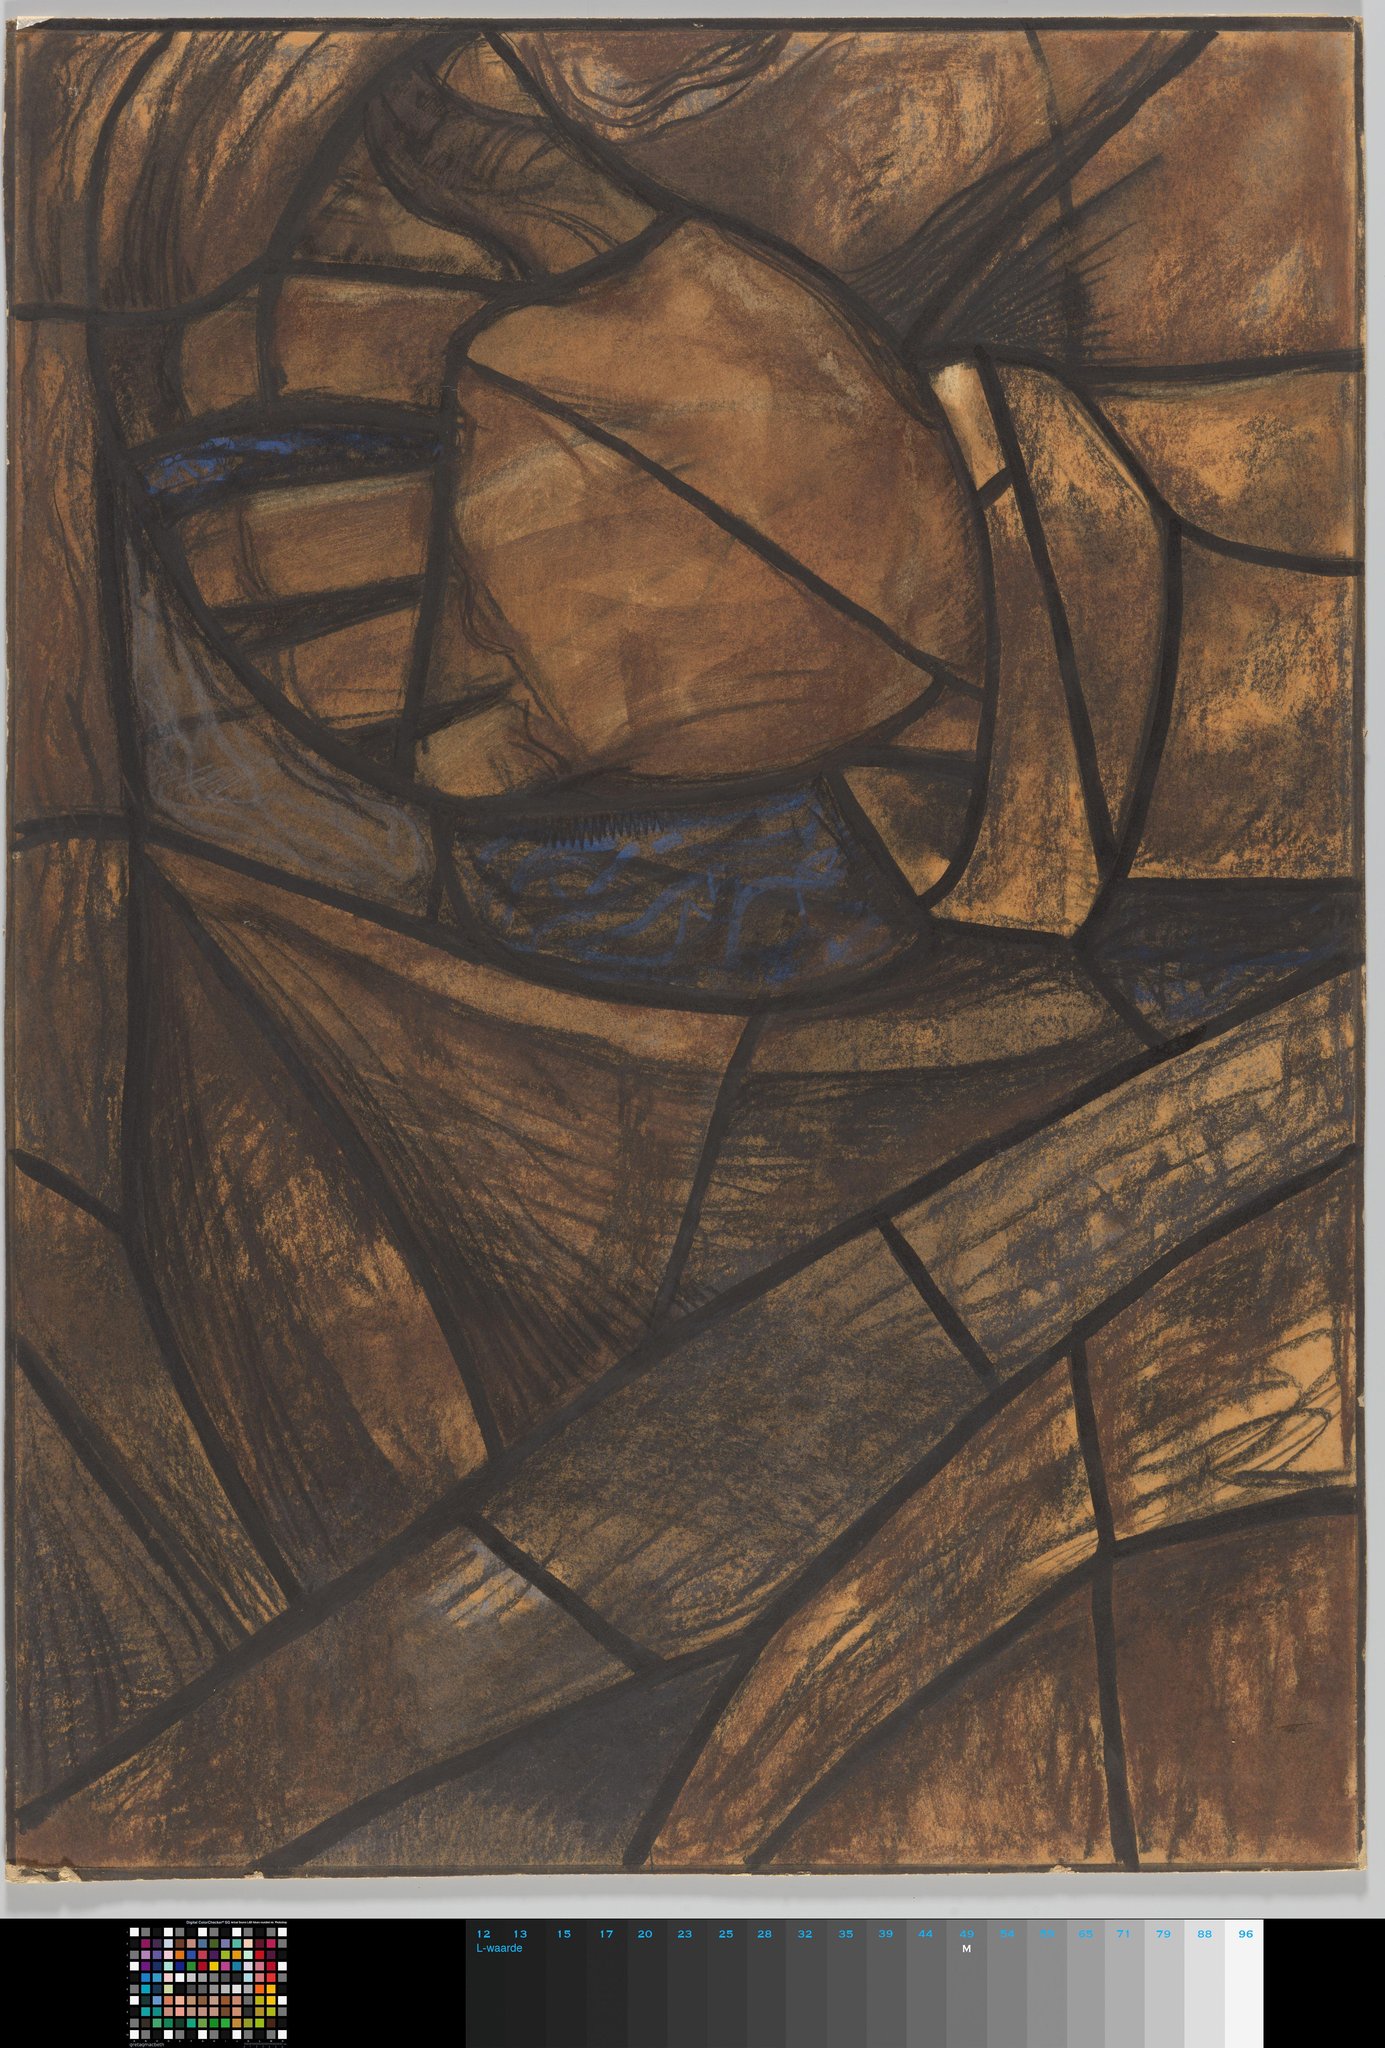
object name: design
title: Ontwerp voor raam in het Noordertransept in de Dom te Utrecht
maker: richard nicolaüs roland holst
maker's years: 1868-1938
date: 1934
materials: cardboard, chalk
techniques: brush